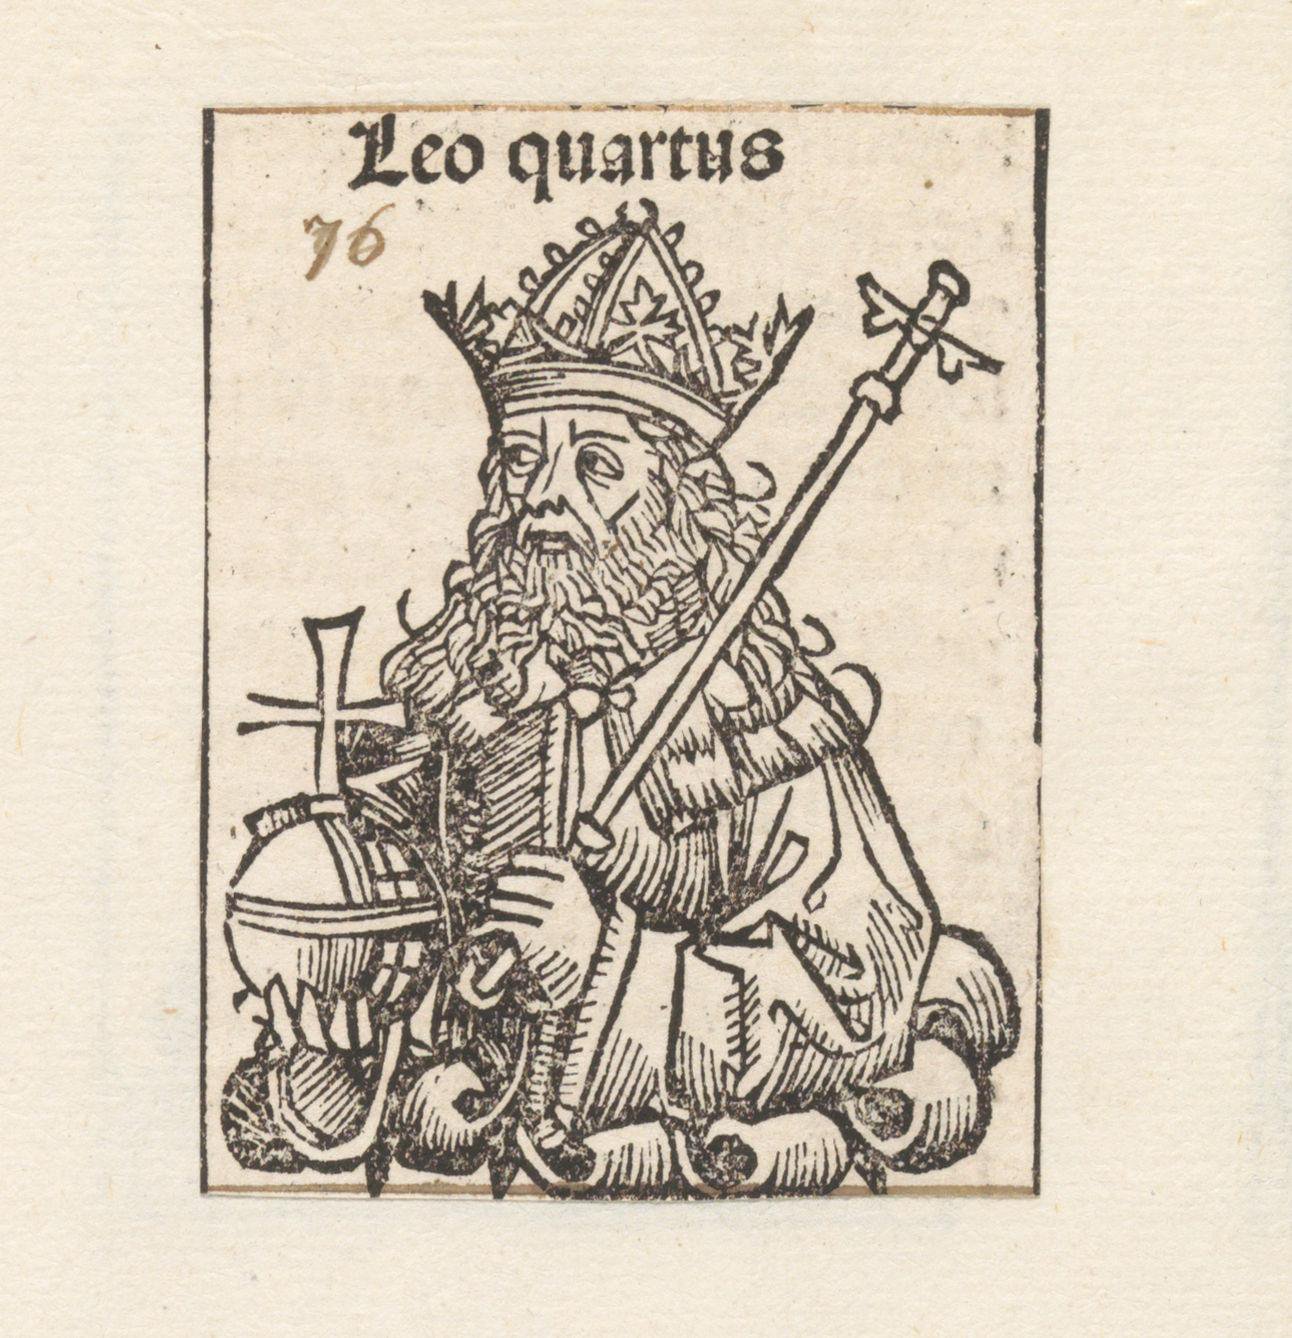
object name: book illustration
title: Keizer Leo IV van Byzantium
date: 1493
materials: paper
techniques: letterpress printing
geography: nuremberg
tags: emperor, king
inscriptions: inscription: ‘76’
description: Een bloemkelk met een koning. Hij heeft een rijksappel en scepter in zijn handen. De voorstelling is onderdeel van de opeenvolging keizers in de Liber Chronicarum. De tekst identificeert de man als keizer Leo IV. De prent maakt deel uit van een album.